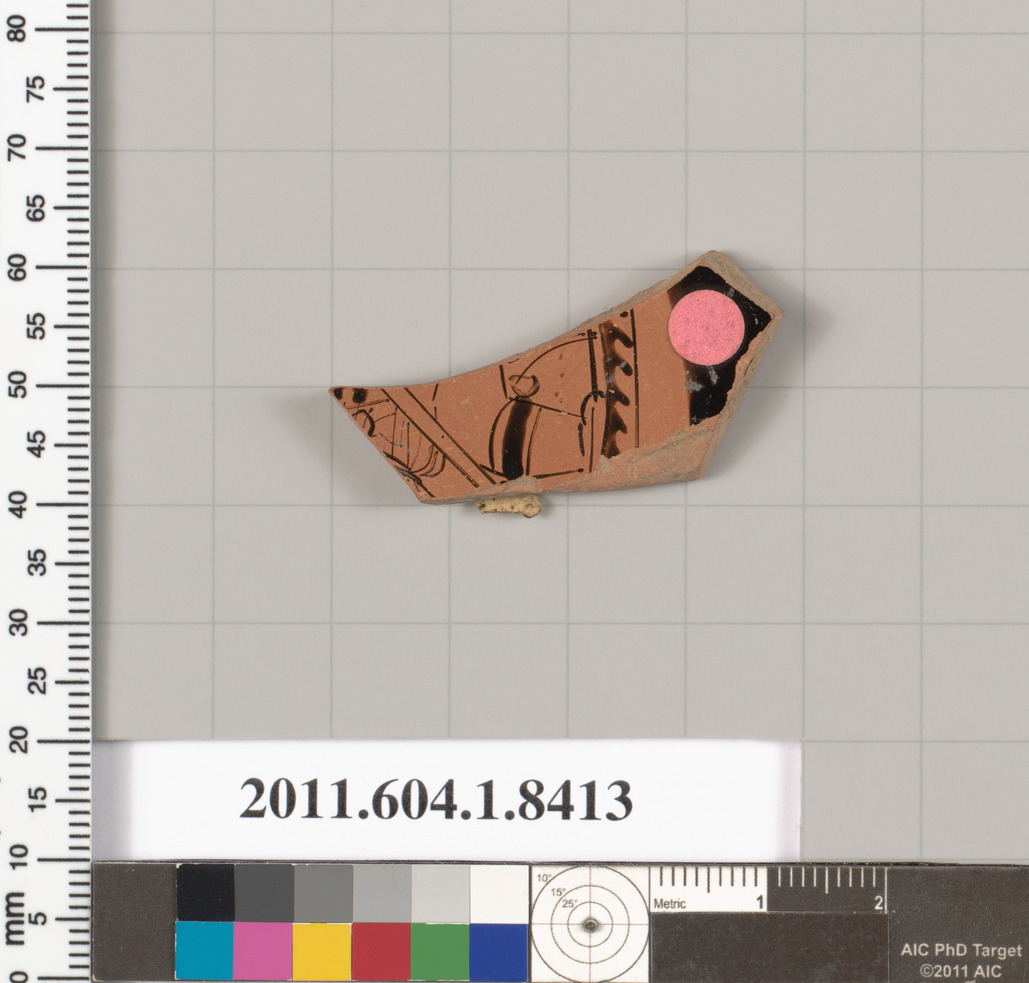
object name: kylix fragment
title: Terracotta fragment of a kylix (drinking cup)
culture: greek, attic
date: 434-401 BCE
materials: terracotta